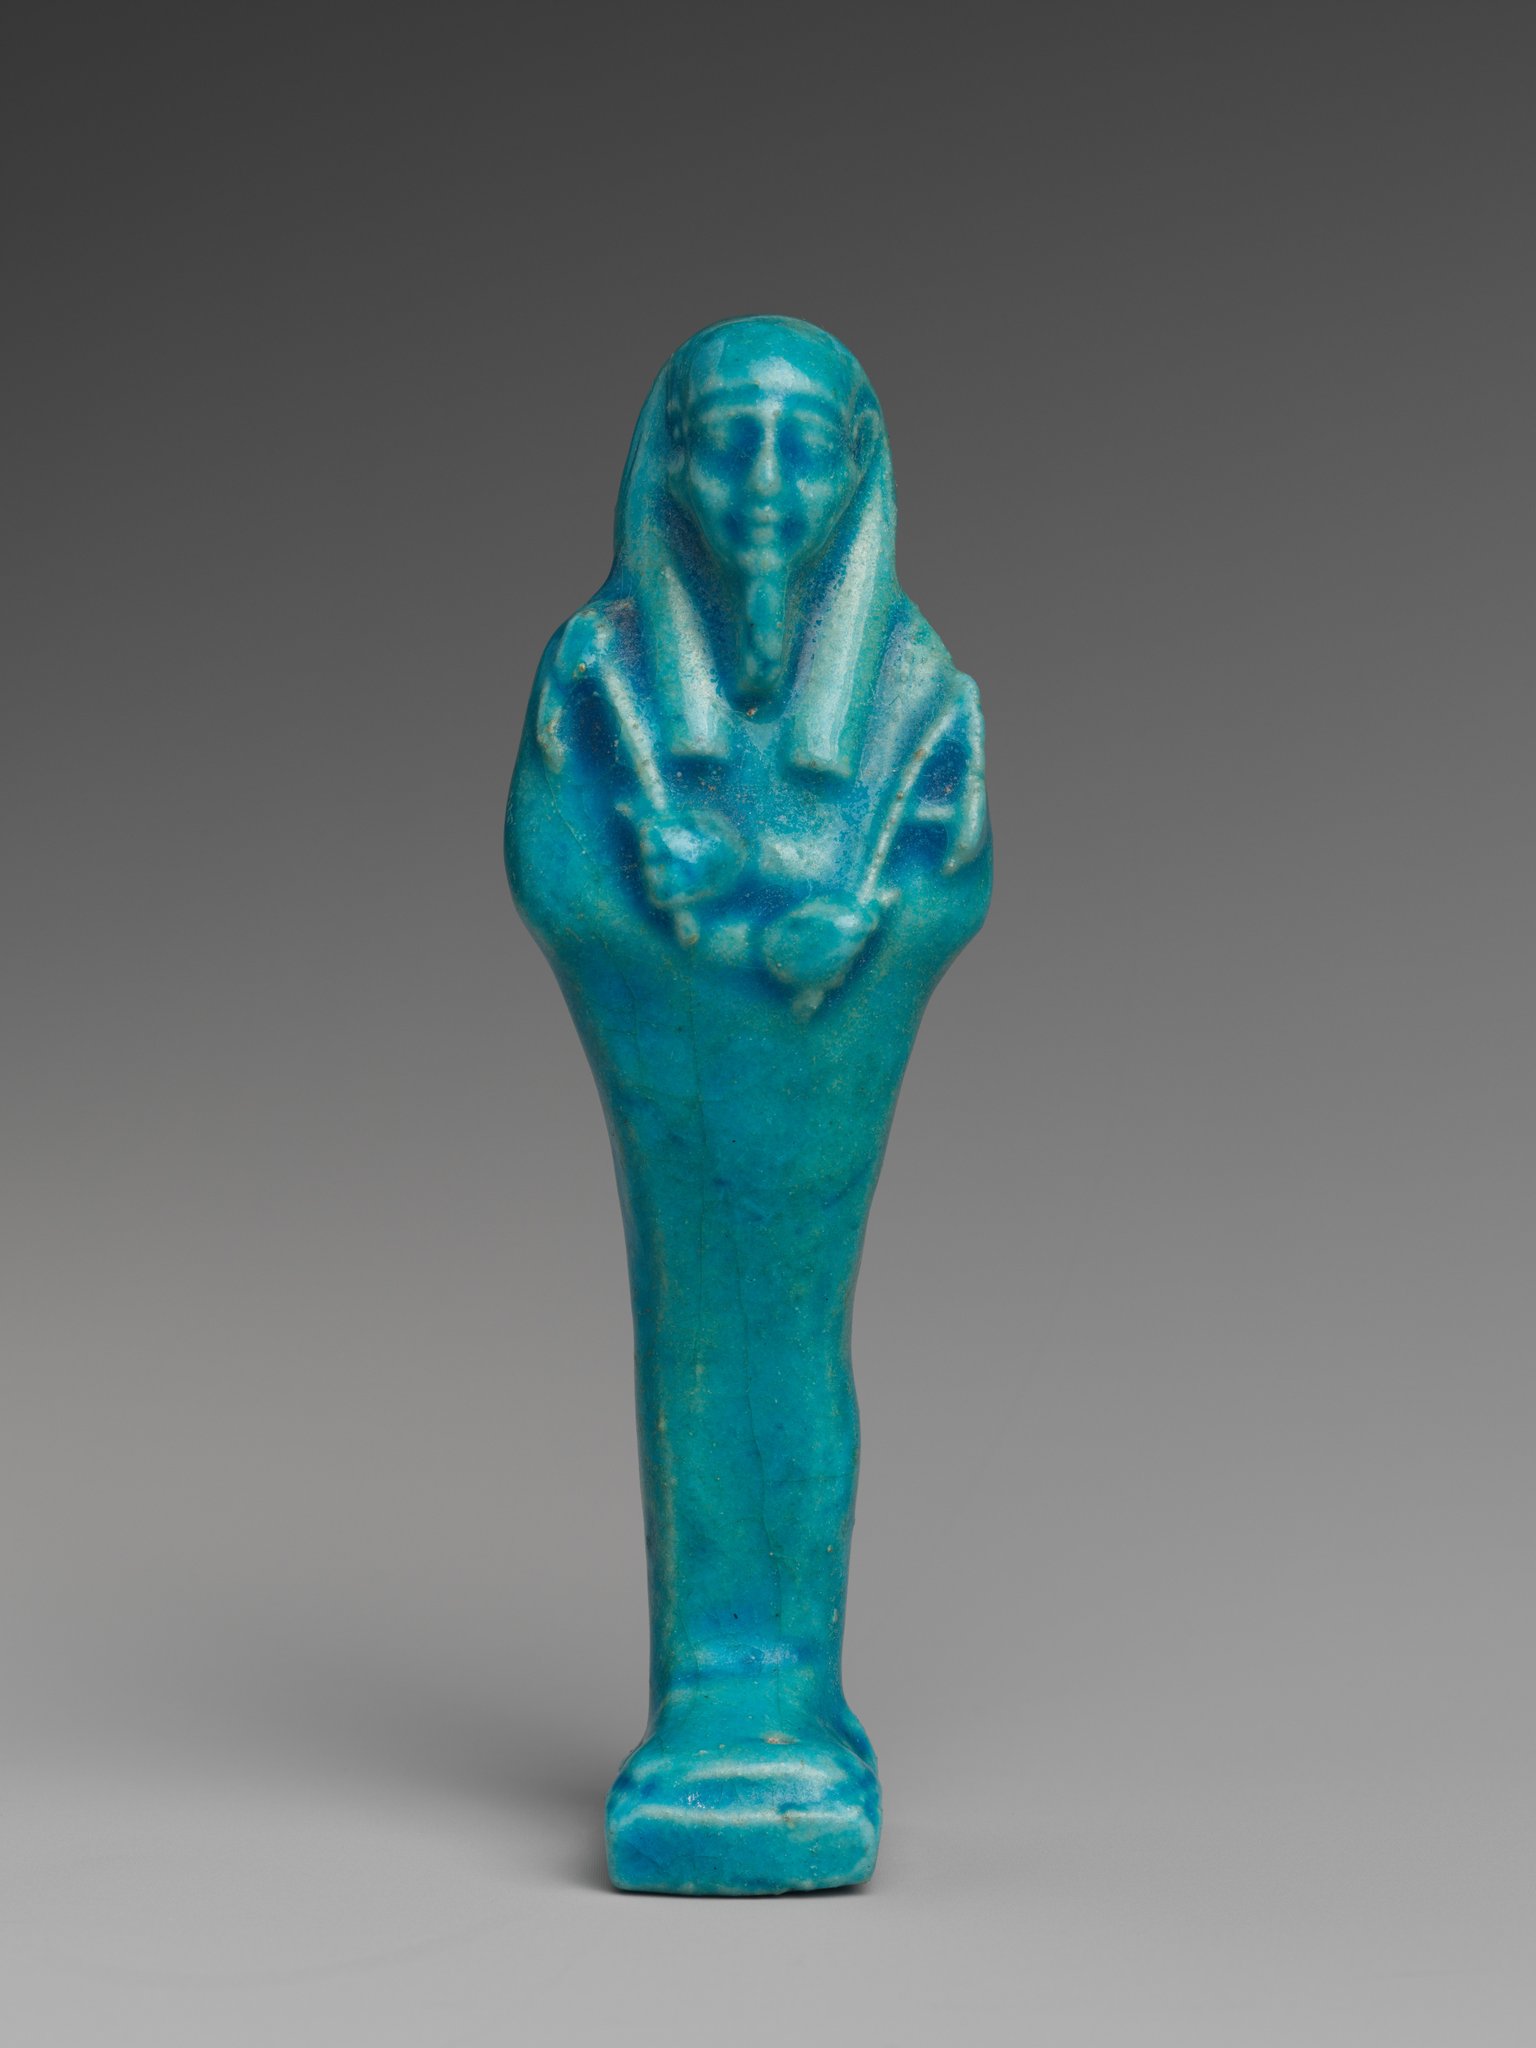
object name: shabti, petosiris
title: Shabti of Petosiris, son of Djedhor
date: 360-300 BCE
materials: faience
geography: egypt